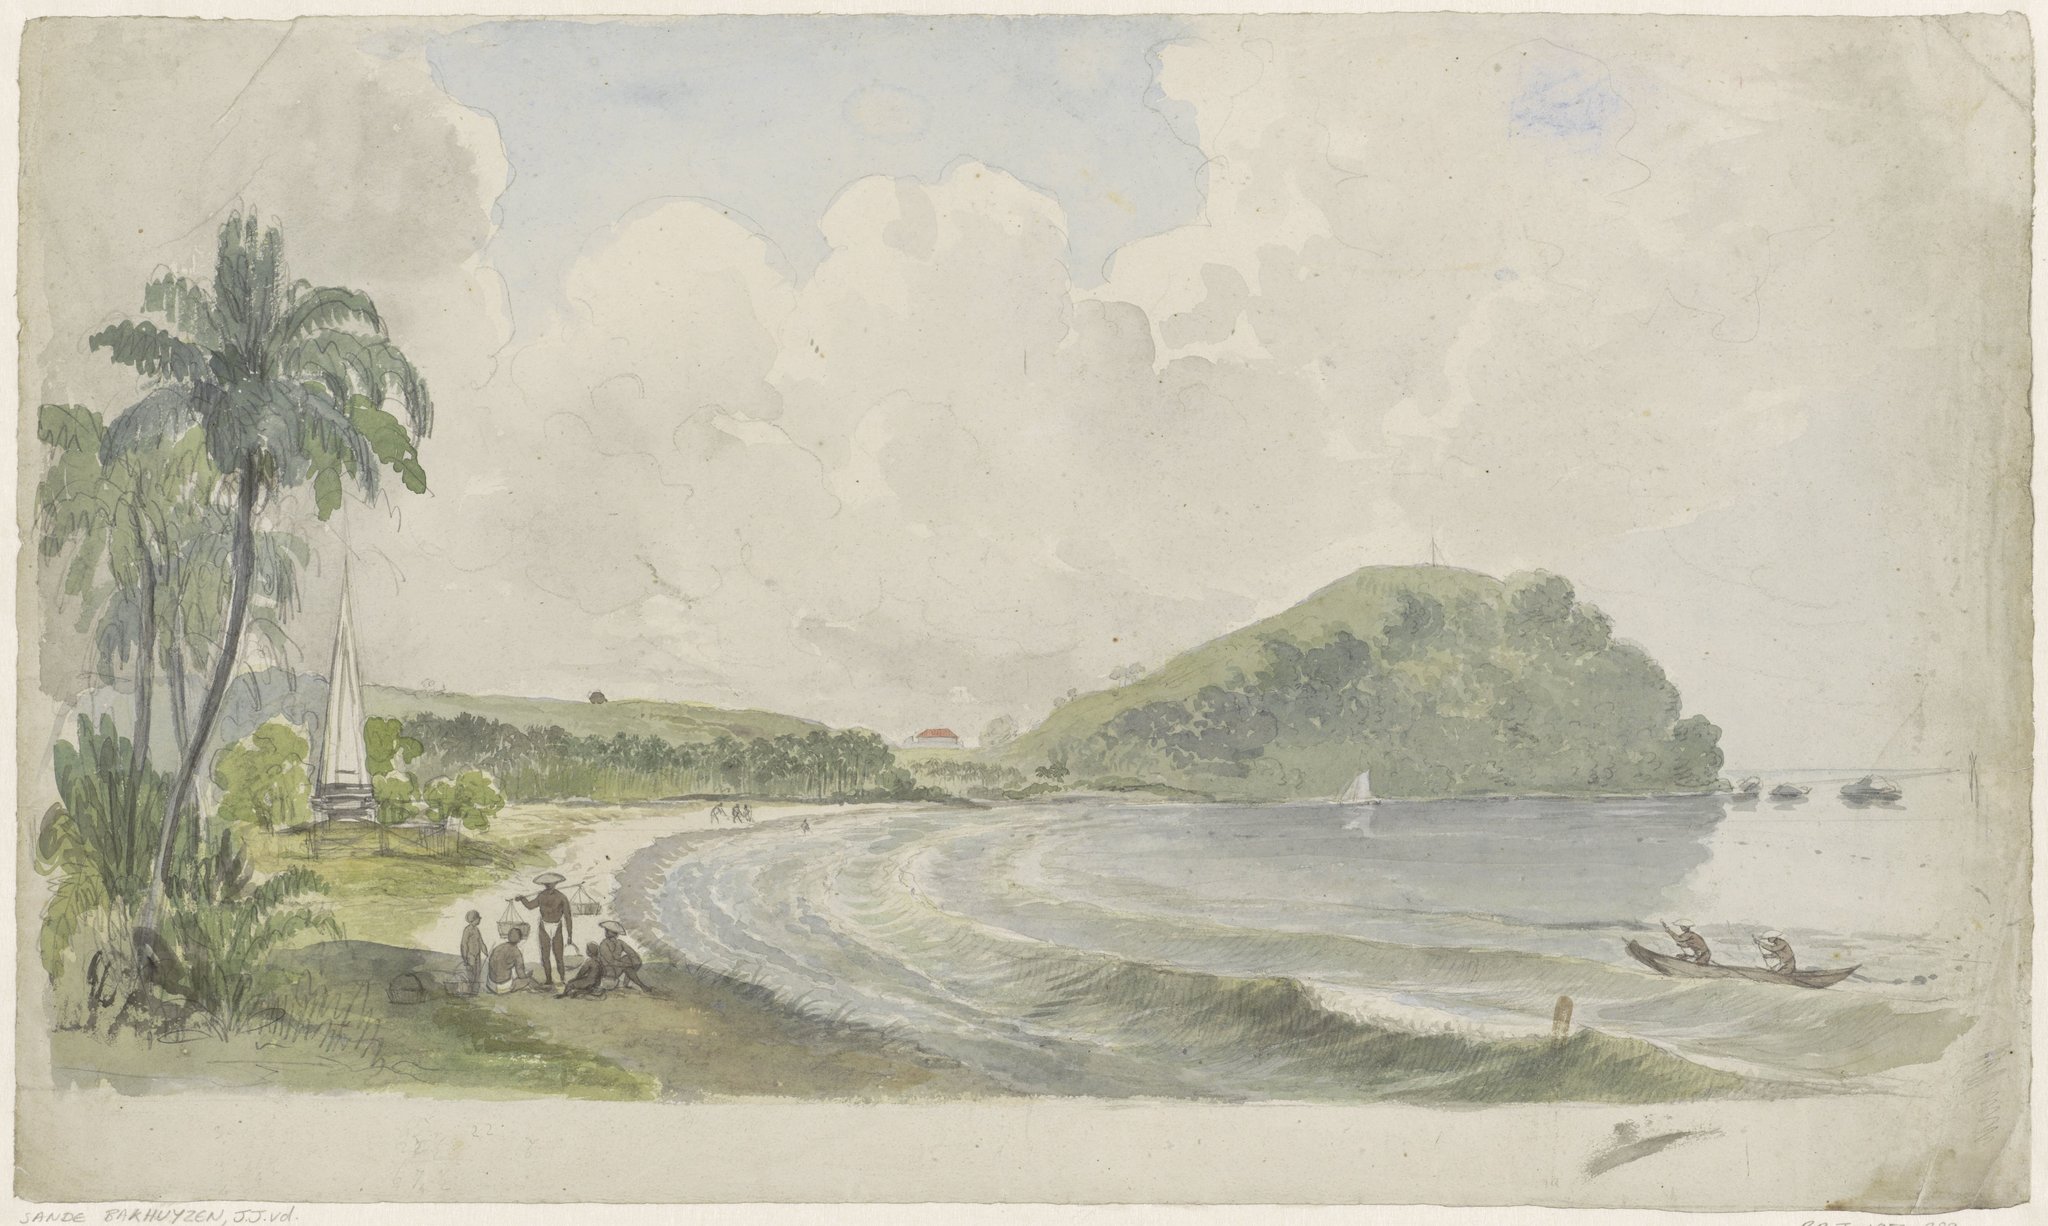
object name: watercolor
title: Tropisch kustlandschap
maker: julius jacobus van de sande bakhuyzen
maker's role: draughtsman, painter, print maker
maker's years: 1835-1925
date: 1845-1925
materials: paper, pencil, watercolor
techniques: brush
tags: coast (in tropical and sub-tropical regions)